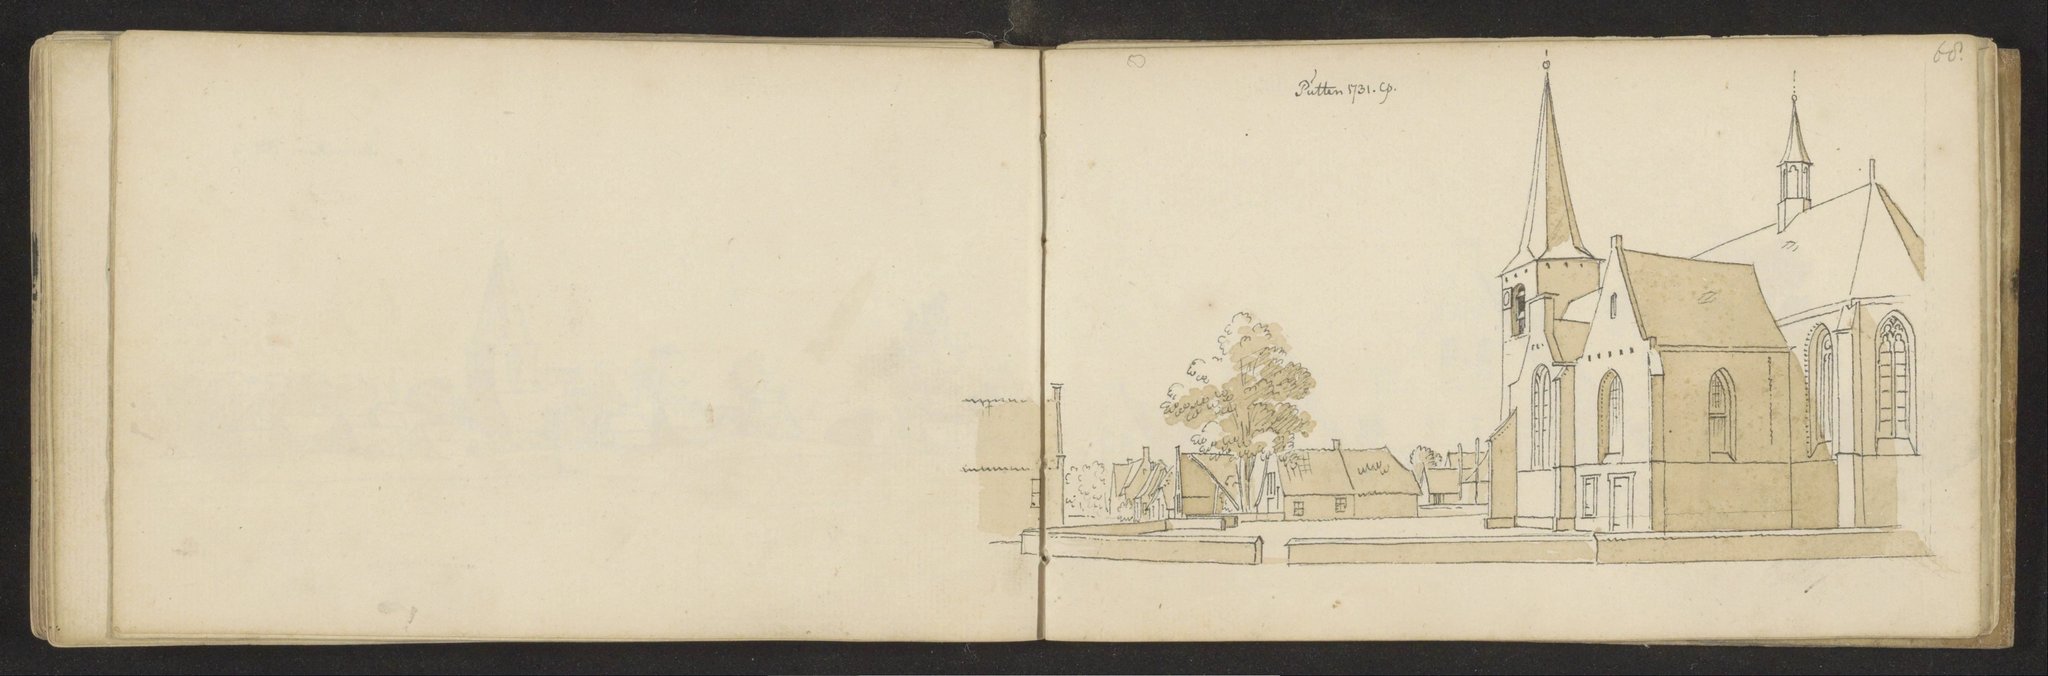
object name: sketchbook leaf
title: Dorpsgezicht te Putten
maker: abraham de haen (ii)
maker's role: draughtsman, print maker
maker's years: 1707-1748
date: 1731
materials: ink, paper, pencil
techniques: brush, pen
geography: putten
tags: village, church (exterior)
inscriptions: date and inscription: ‘Putten 1731.cp.’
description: Blad 67 verso en 68 recto uit een schetsboek met 78 bladen.